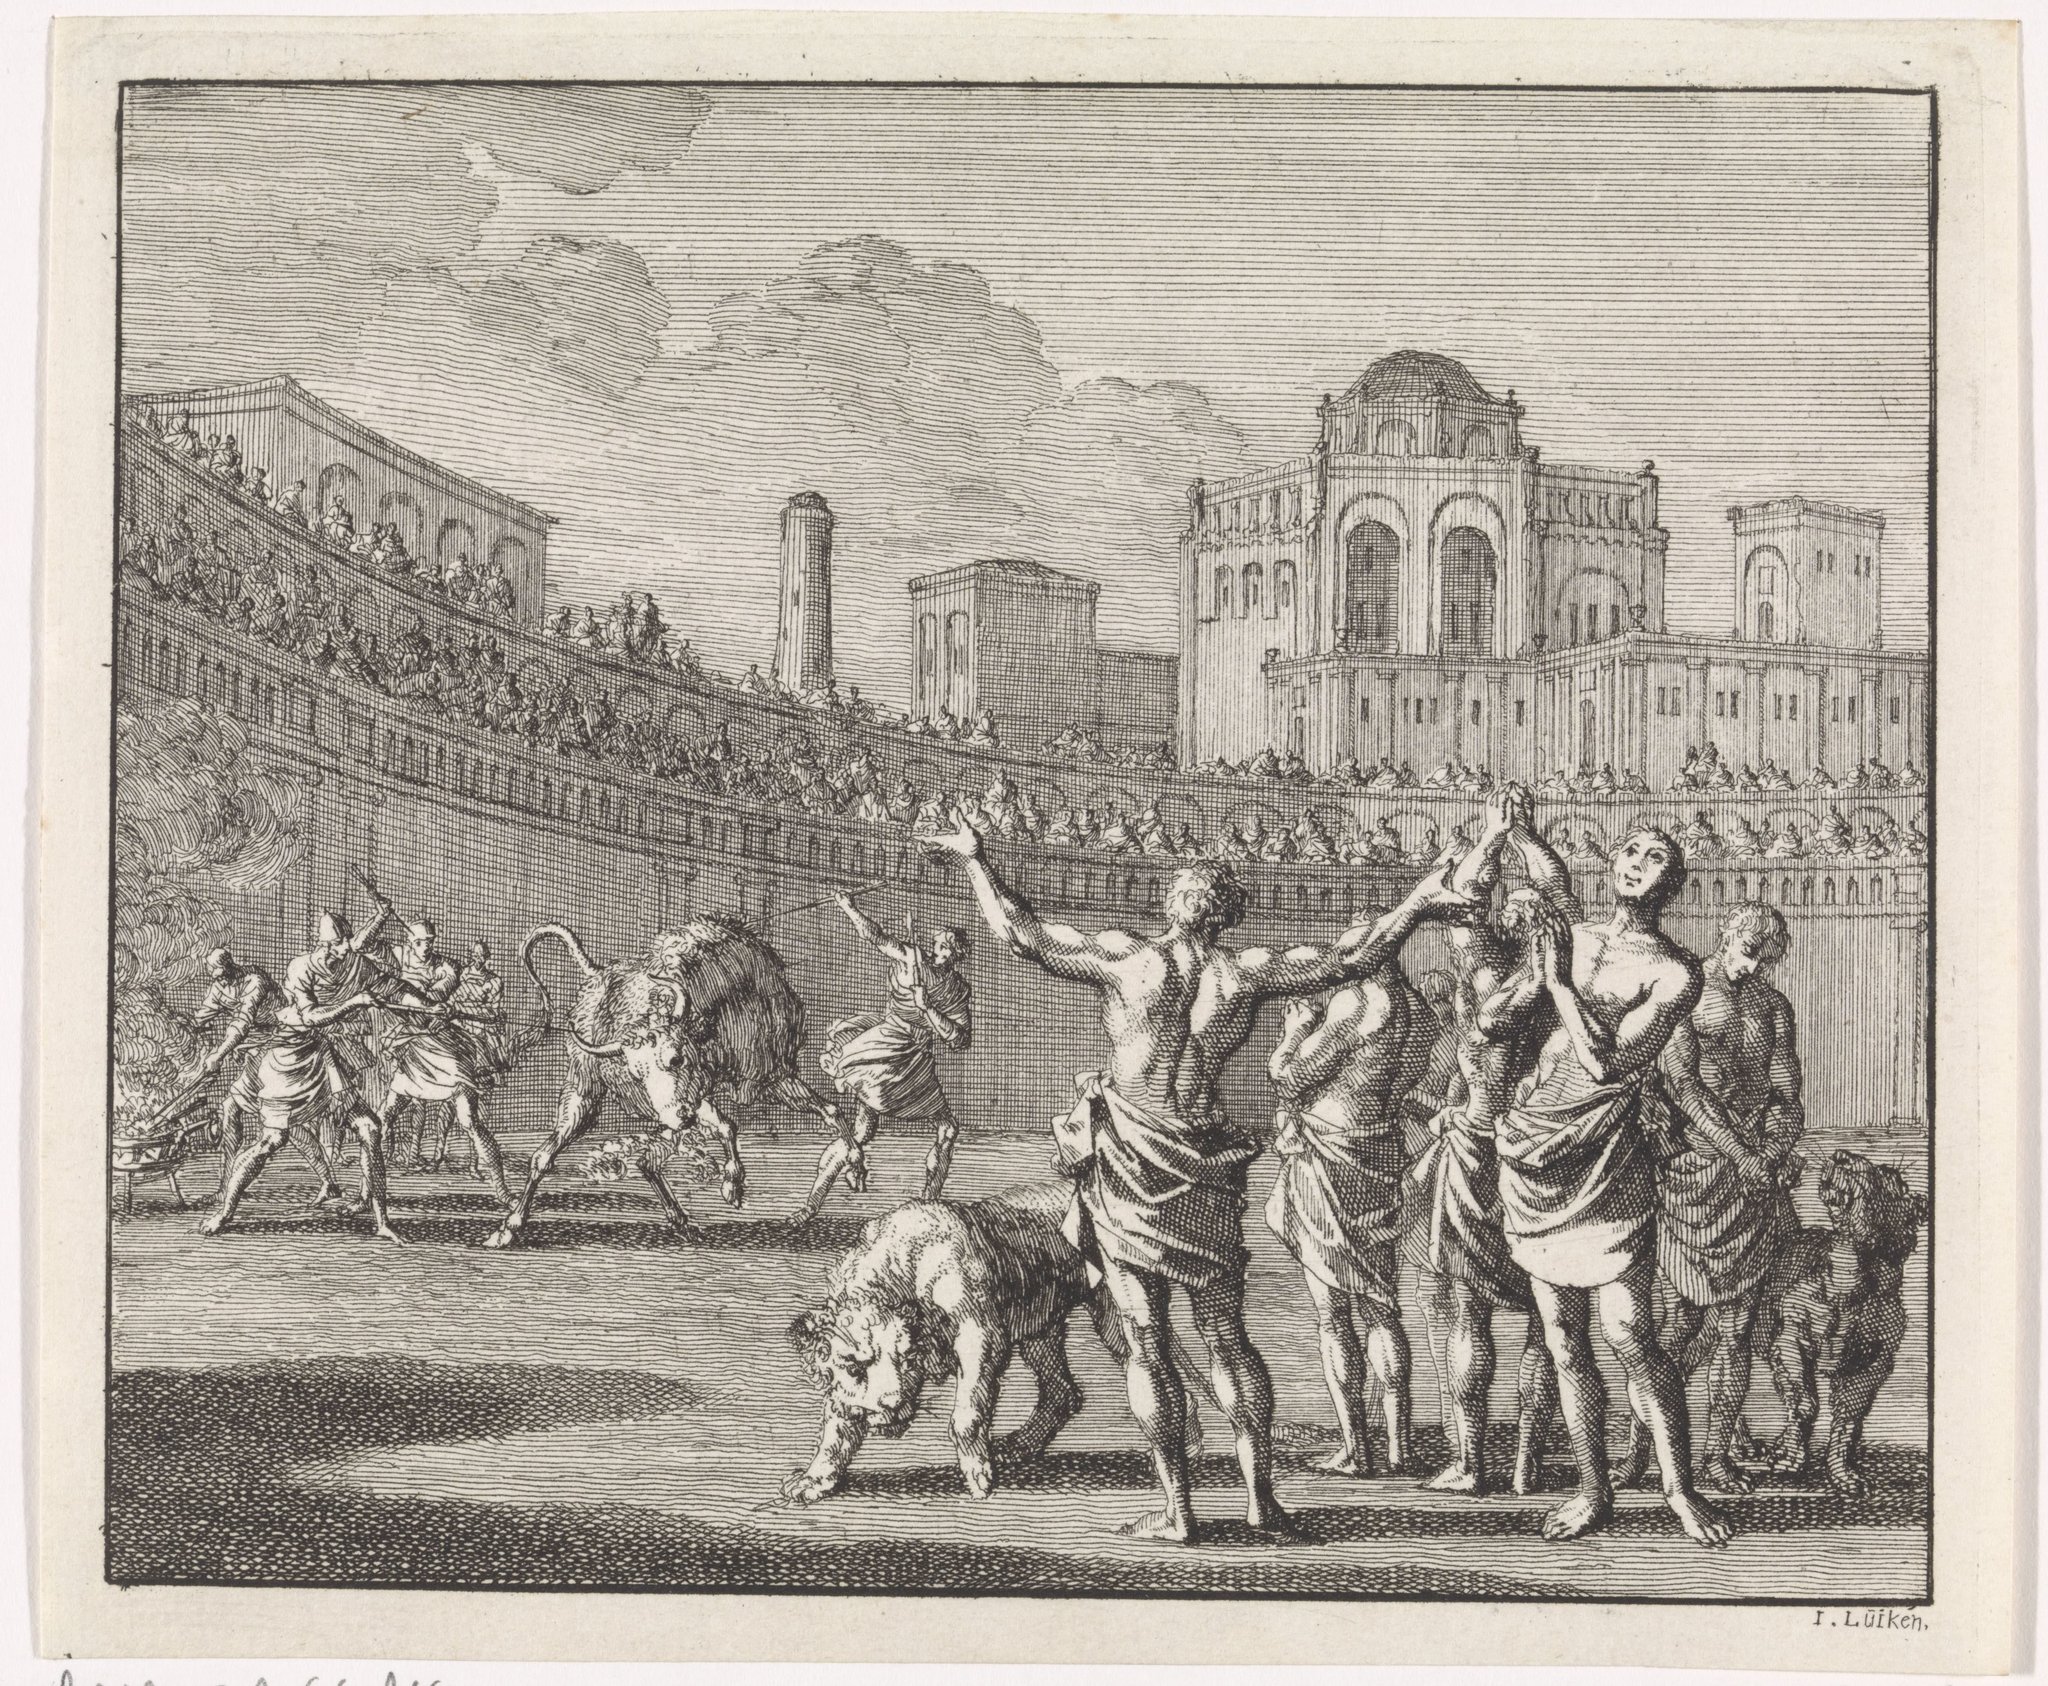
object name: print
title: Vroegchristelijke martelaren in een Romeinse arena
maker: jan luyken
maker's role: draughtsman, print maker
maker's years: 1649-1712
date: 1701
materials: paper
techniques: etching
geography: amsterdam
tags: the early christian churches, e.g. armenians, copts, syrians, bull, martyr(s) (often with palm-branches), beasts of prey, predatory animals: lion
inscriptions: collector's mark: Lugt 2228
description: Een Romeinse arena met op de voorgrond enkele vroegchristelijke martelaren. Rondom de christenen enkele leeuwen. Op de achtergrond trachten soldaten een stier richting de christenen te mennen door middel van hete pookijzers.